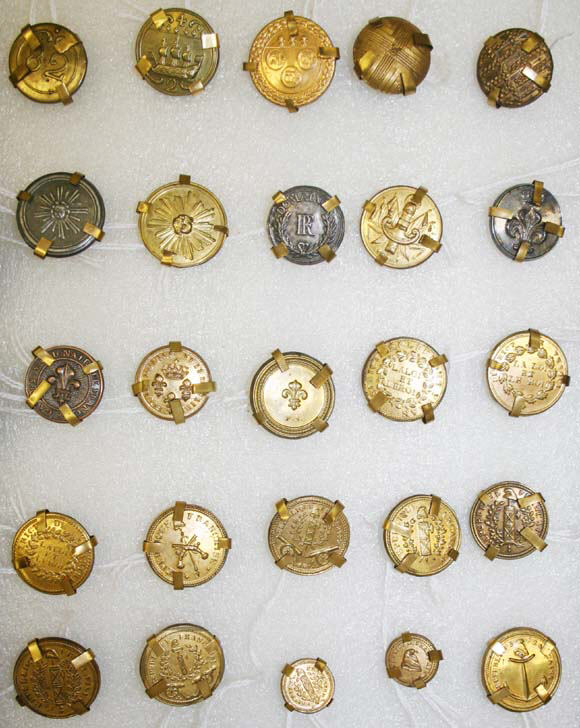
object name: button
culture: french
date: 1780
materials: bone, wood